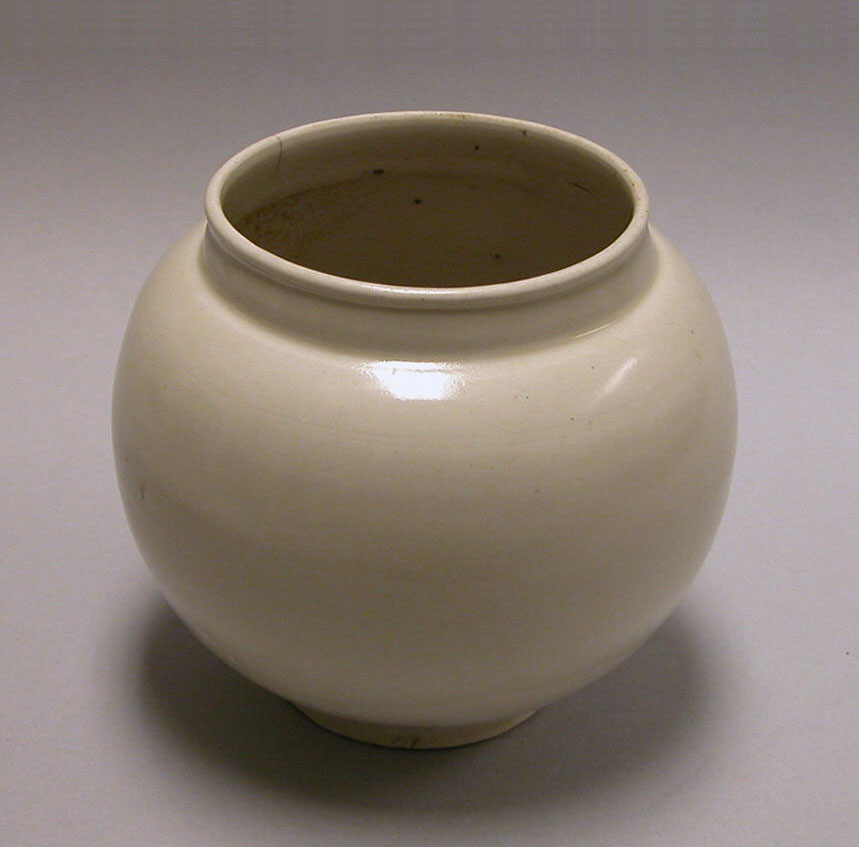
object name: jar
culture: chinese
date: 901-1100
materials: glaze, ivory, porcelain